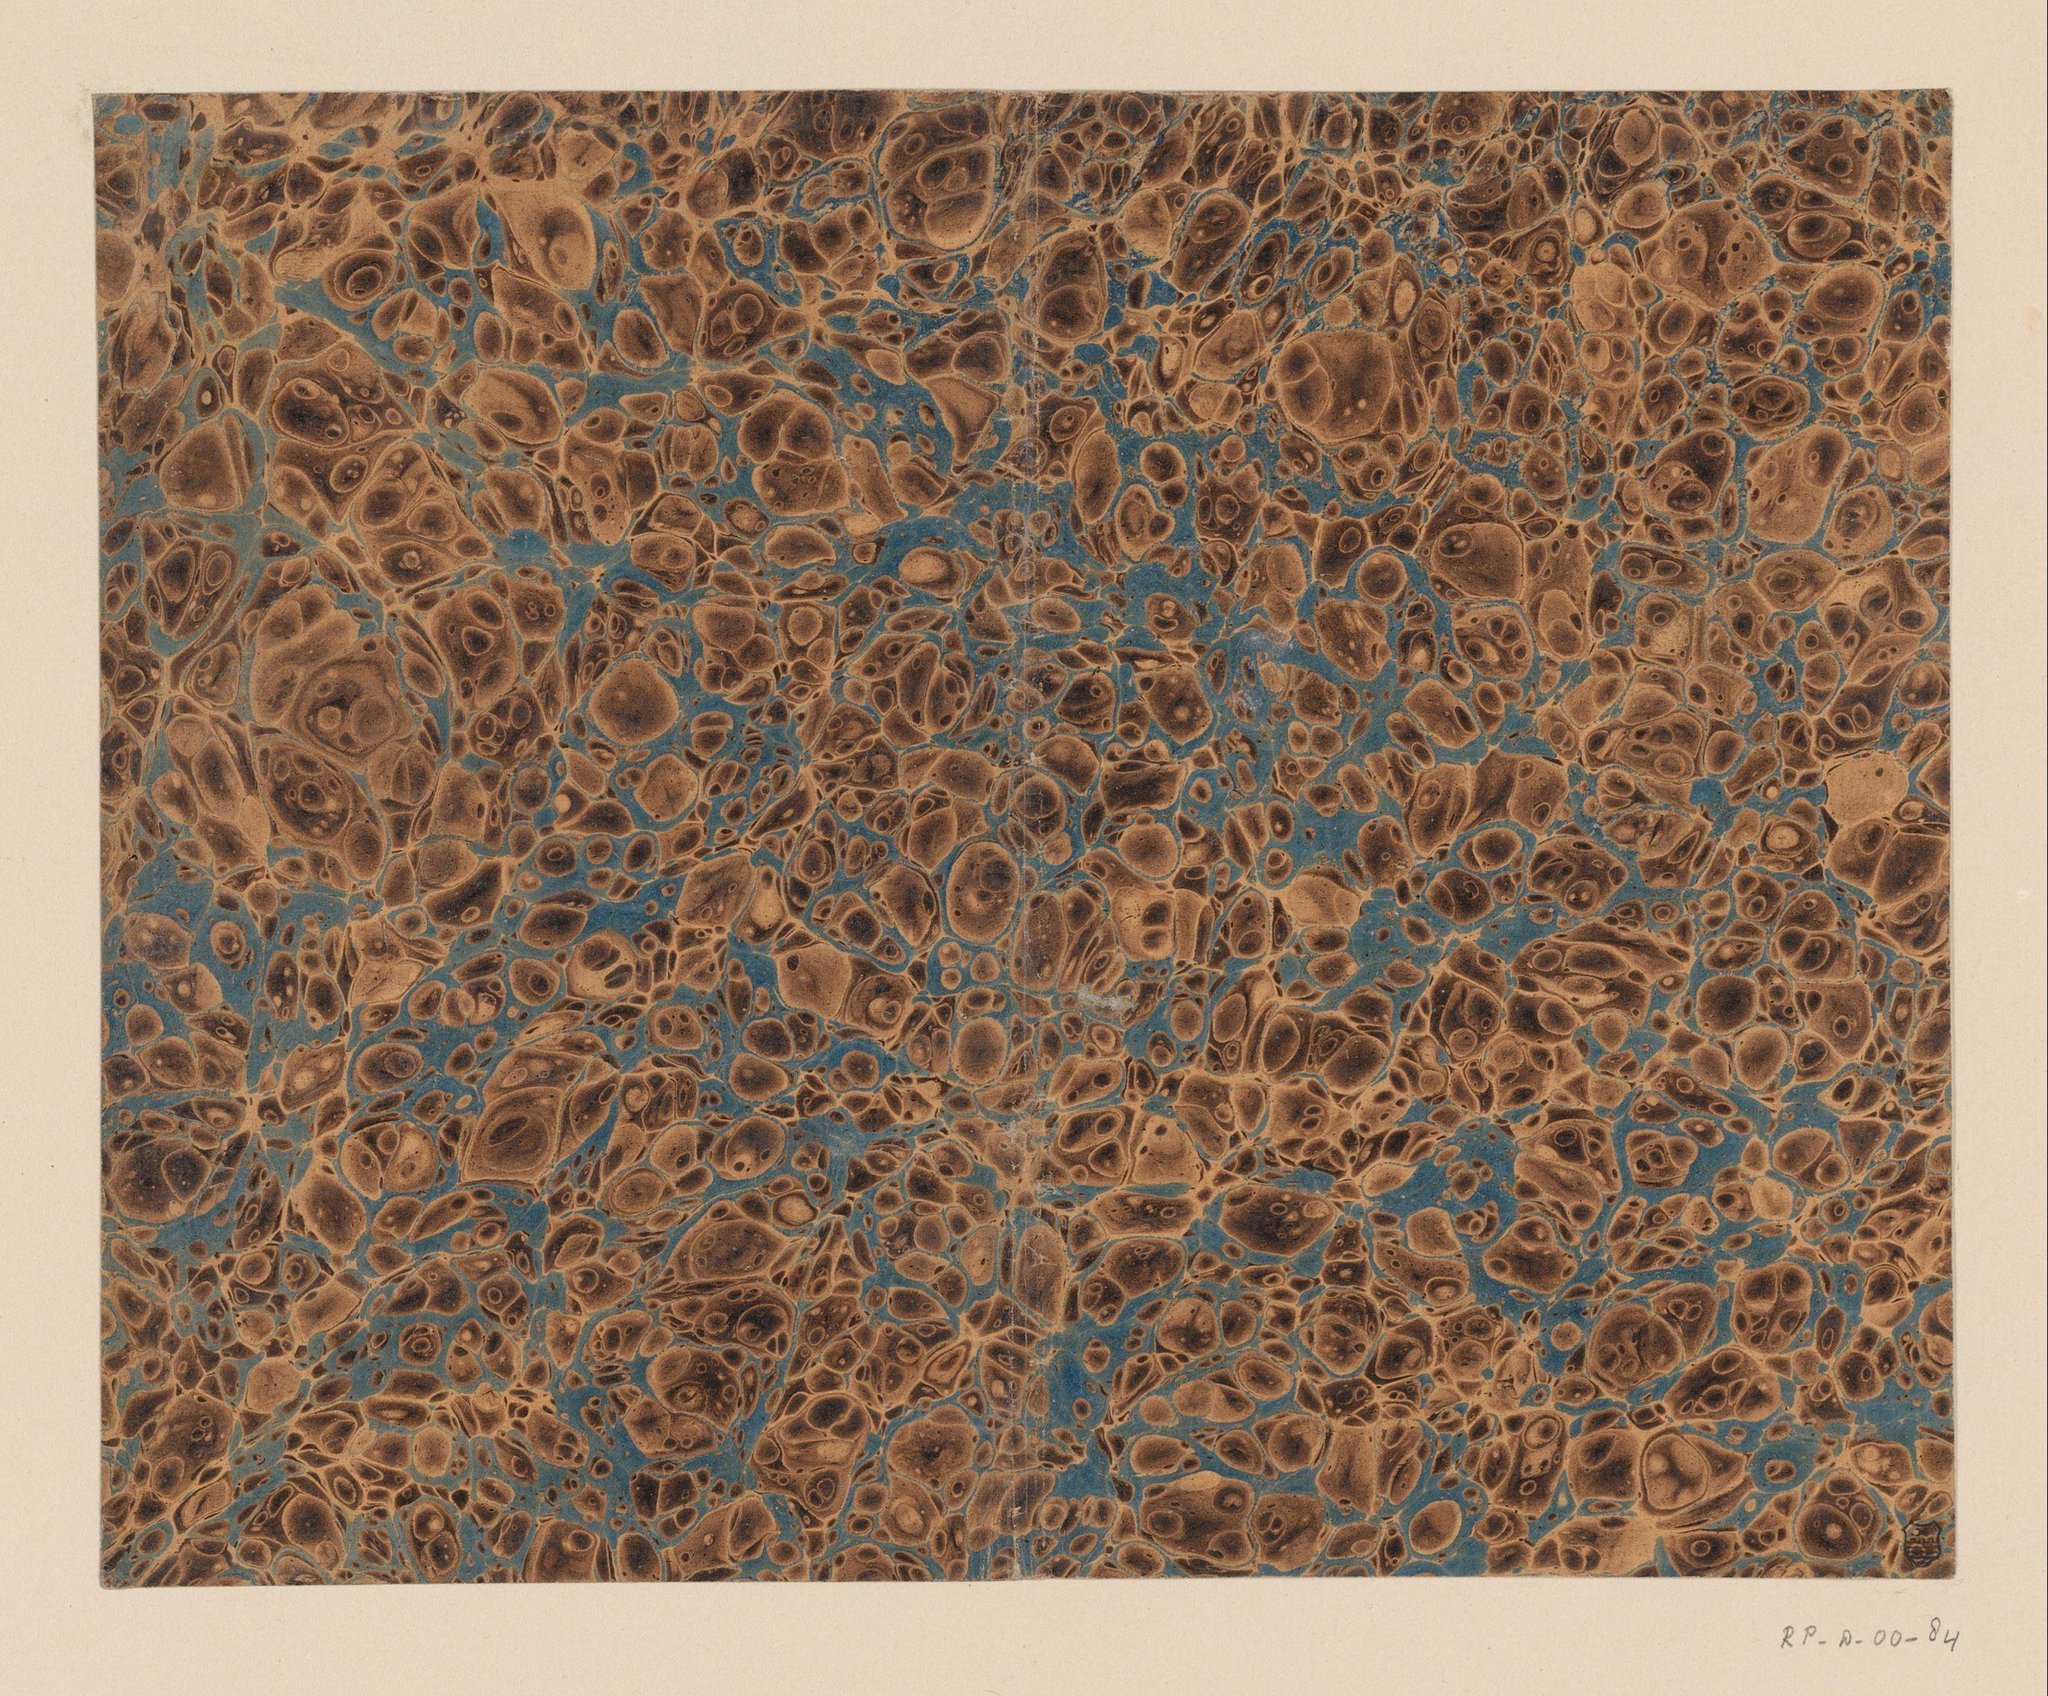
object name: wrapper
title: Ringkiezelmarmer in blauw en bruin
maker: Anonymous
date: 1700-1850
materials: paint, paper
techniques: marbled paper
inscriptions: collector's mark: Lugt 2760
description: Ringkiezelmarmer in blauw en bruin. Gebruikt als omslag.